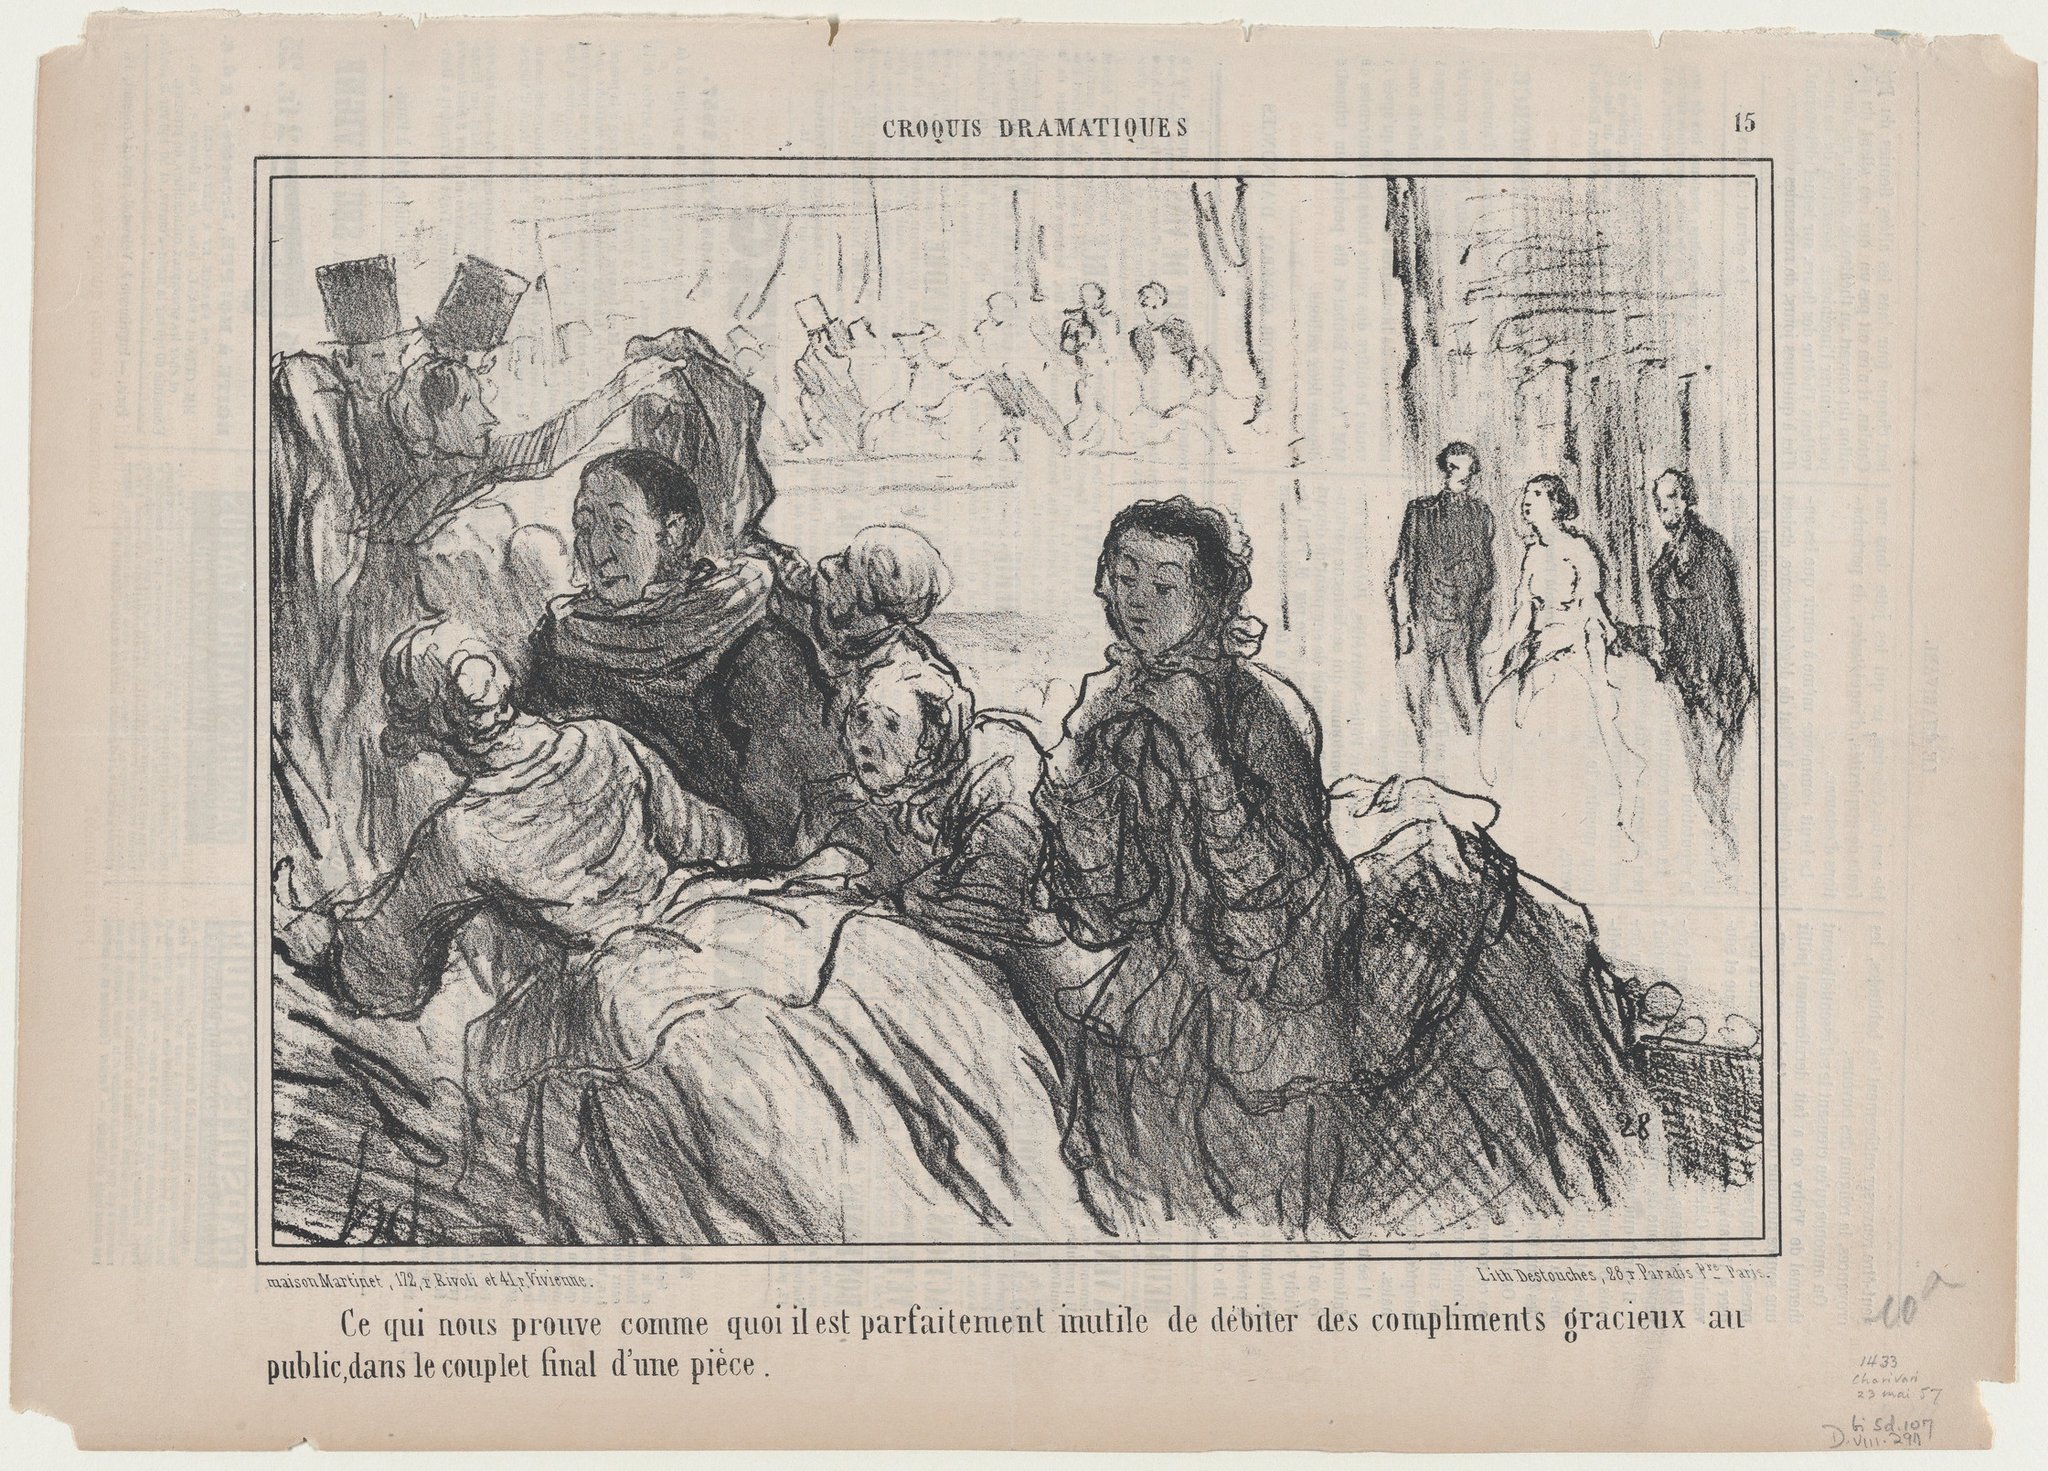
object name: print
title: Ce qui nous prouve comme quoi il est... inutile..., from Croquis Dramatiques, published in Le Charivari, May 23, 1857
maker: honoré daumier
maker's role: artist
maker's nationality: french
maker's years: 1808-1879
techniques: lithograph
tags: men,women